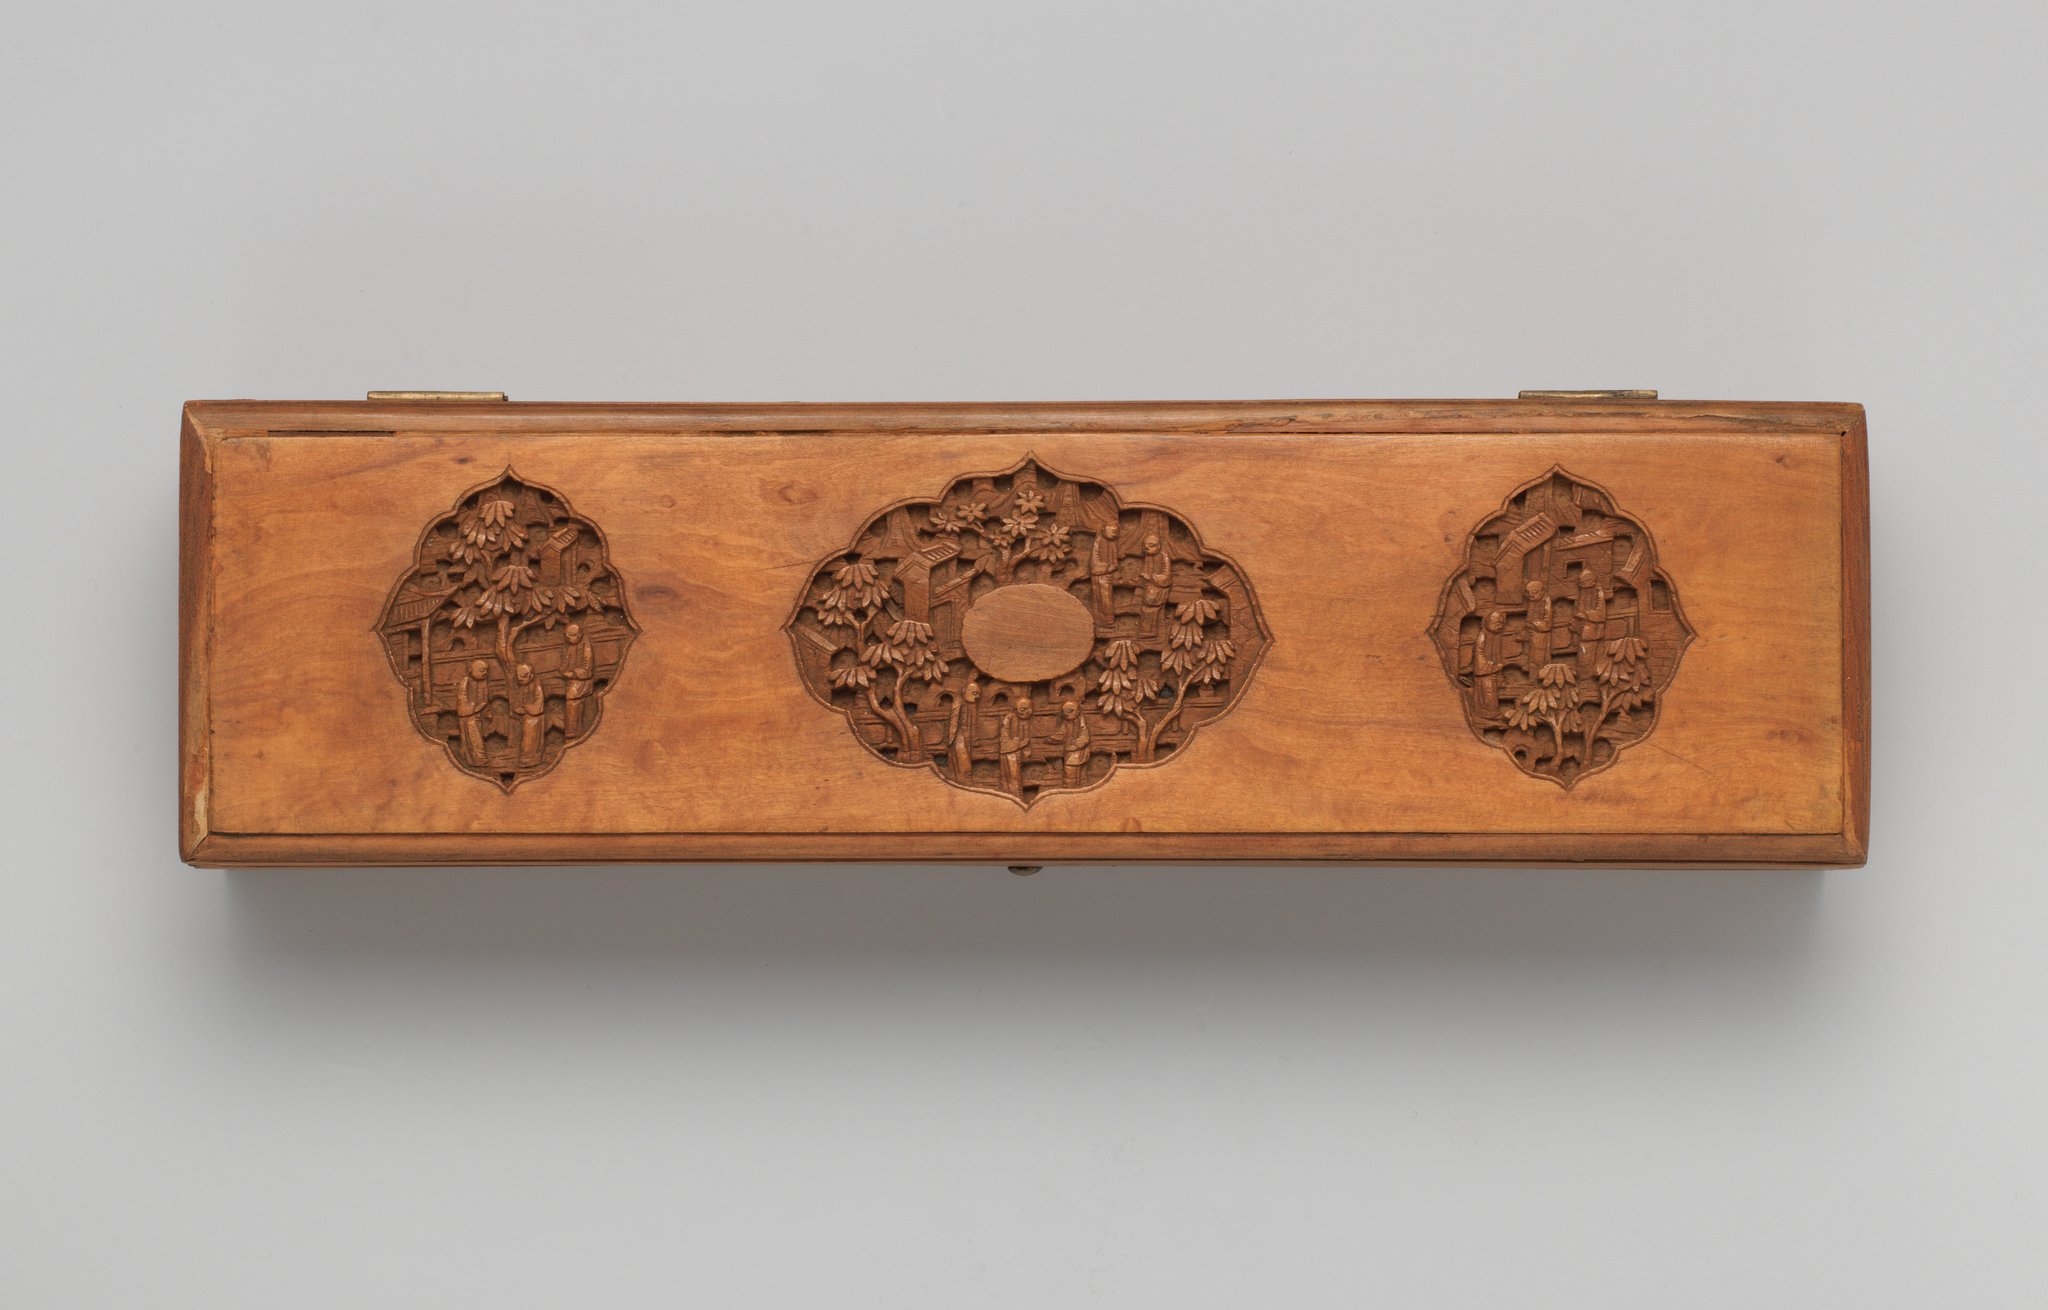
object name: fan box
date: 1801-1900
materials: glass, paper, silk, wood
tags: human figures,flowers,leaves,trees